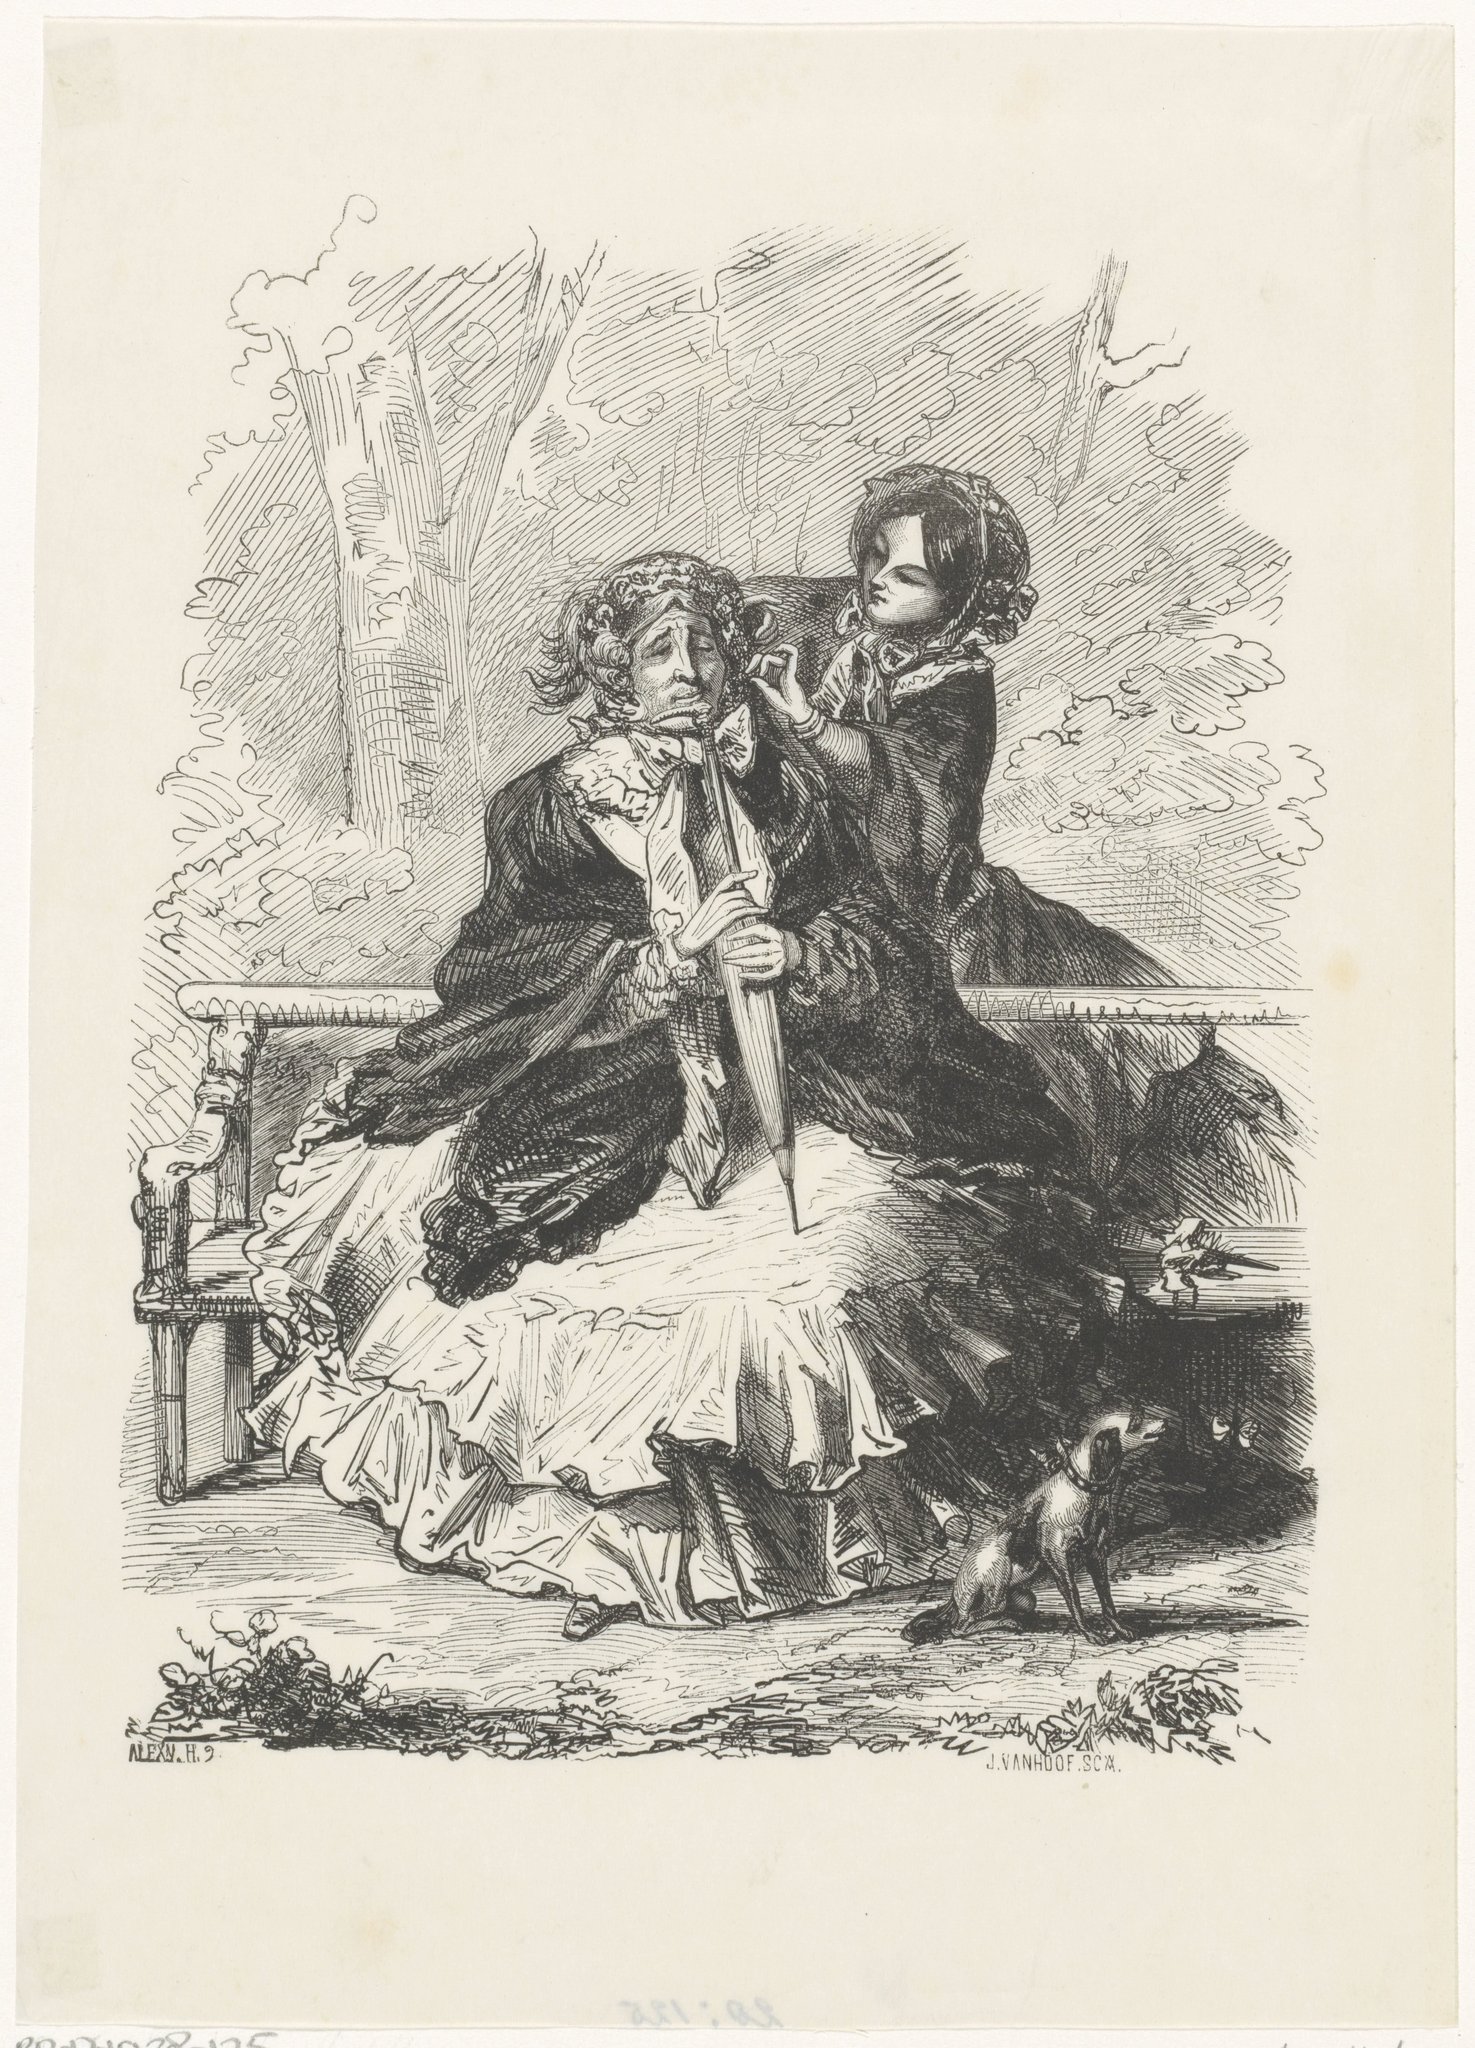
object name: print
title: Dame in park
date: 1850-1914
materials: paper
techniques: engraving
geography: netherlands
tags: bench, head-gear, umbrella, public gardens, park, dog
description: Een vrouw met een paraplu zit op een bank in het park. Achter haar staat een jonge vrouw die het kapje van de dame over haar haren heentrekt. Op de bank ligt een tweede paraplu. Op de voorgrond zit een kleine hond.